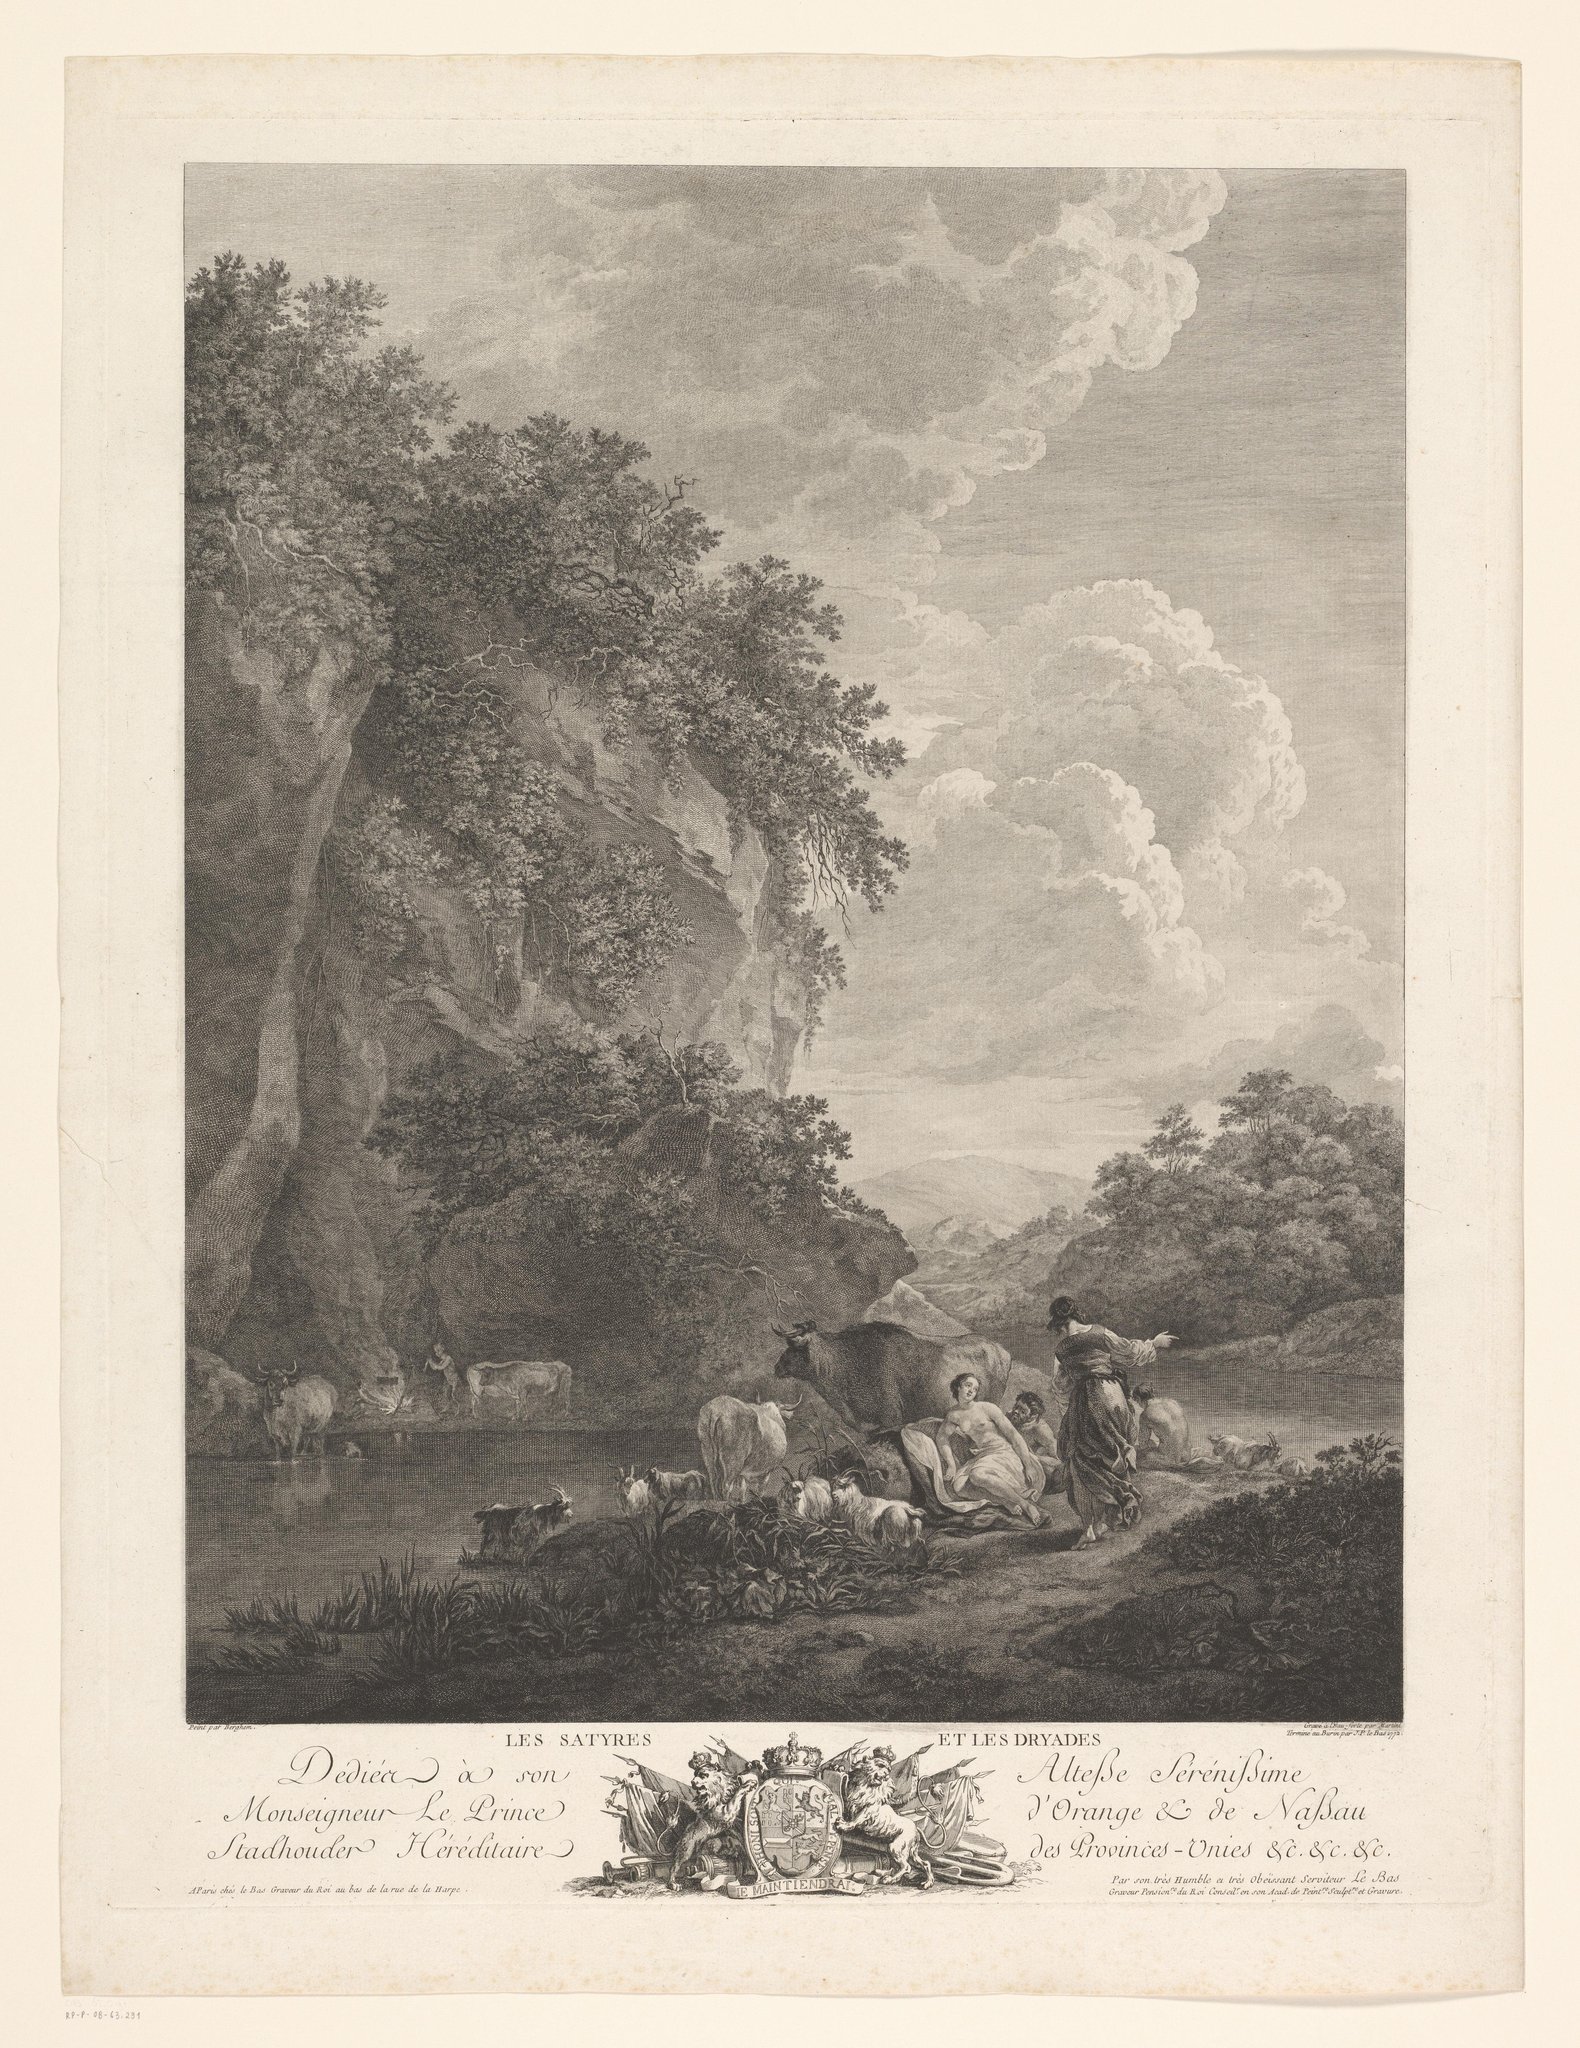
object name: print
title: Saters en dryaden aan de oever van een rivier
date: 1772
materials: paper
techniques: engraving, etching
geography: paris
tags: satyr(s) (in general), giving water, feeding (cattle), (hama)dryads, forest- and tree-nymphs; 'driadi & hamadriadi' (ripa)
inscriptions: collector's mark: Lugt 240